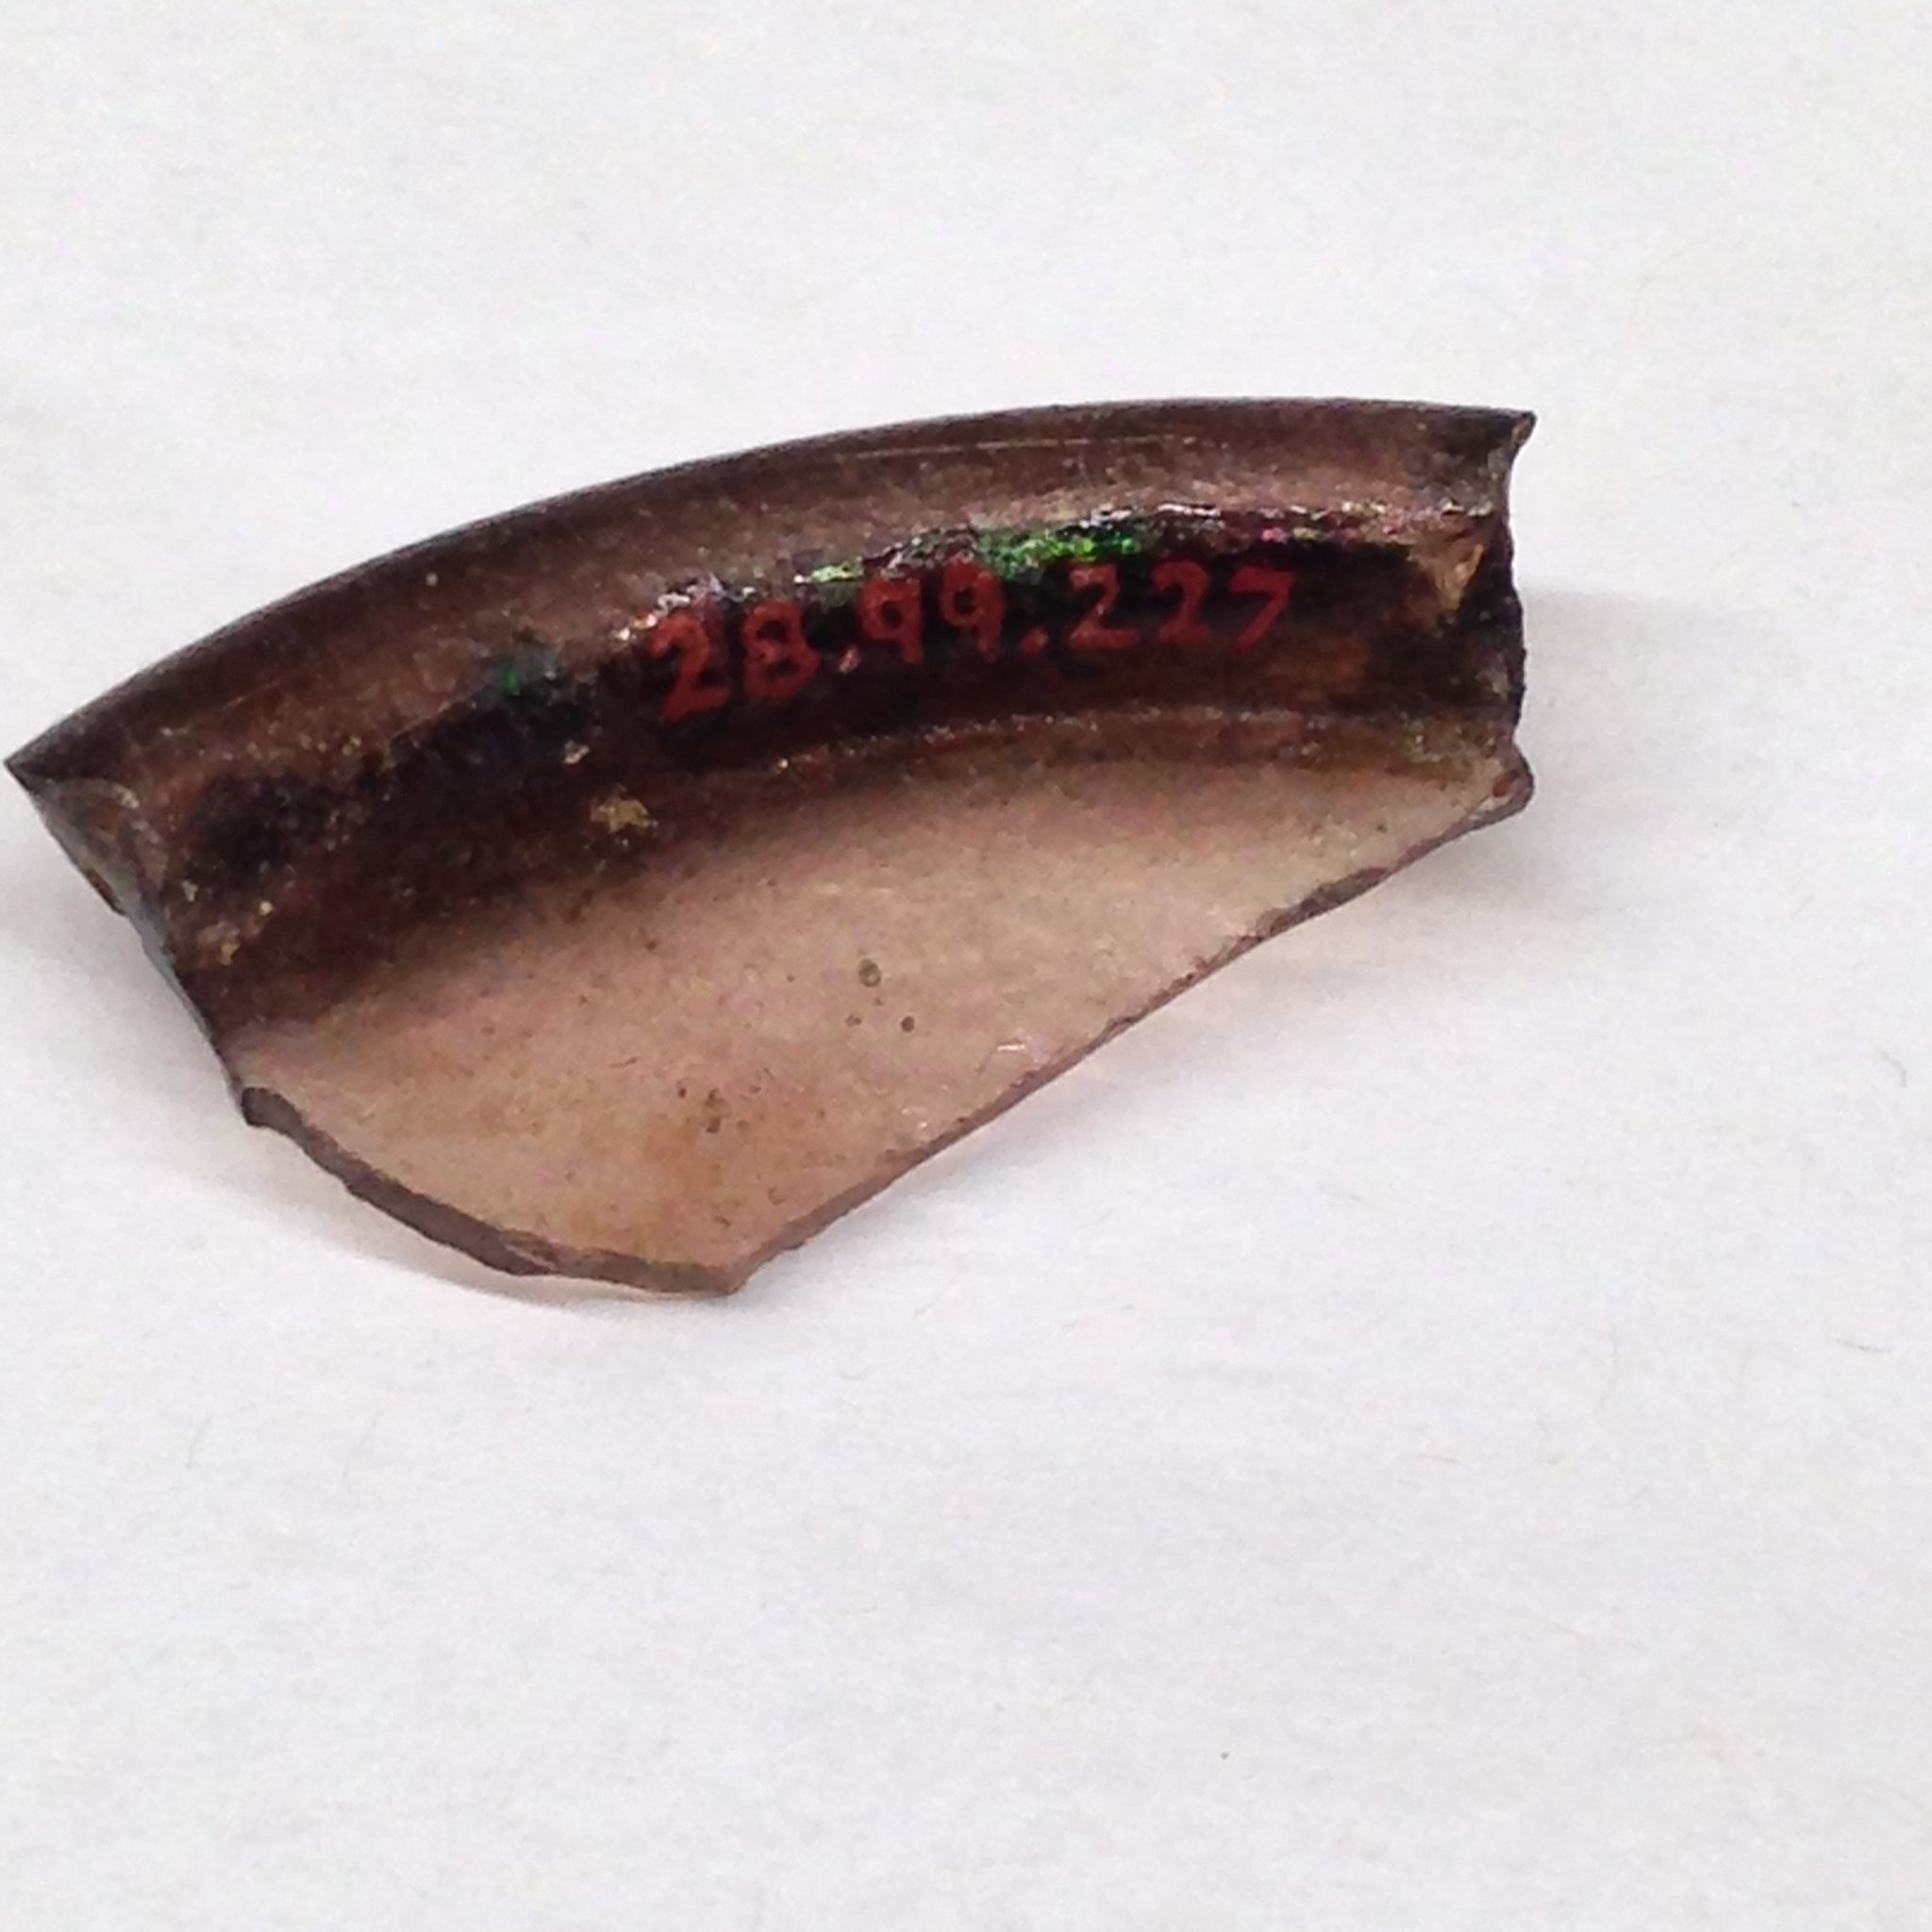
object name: fragment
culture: european or middle eastern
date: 1150-1250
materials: ceramic, glass